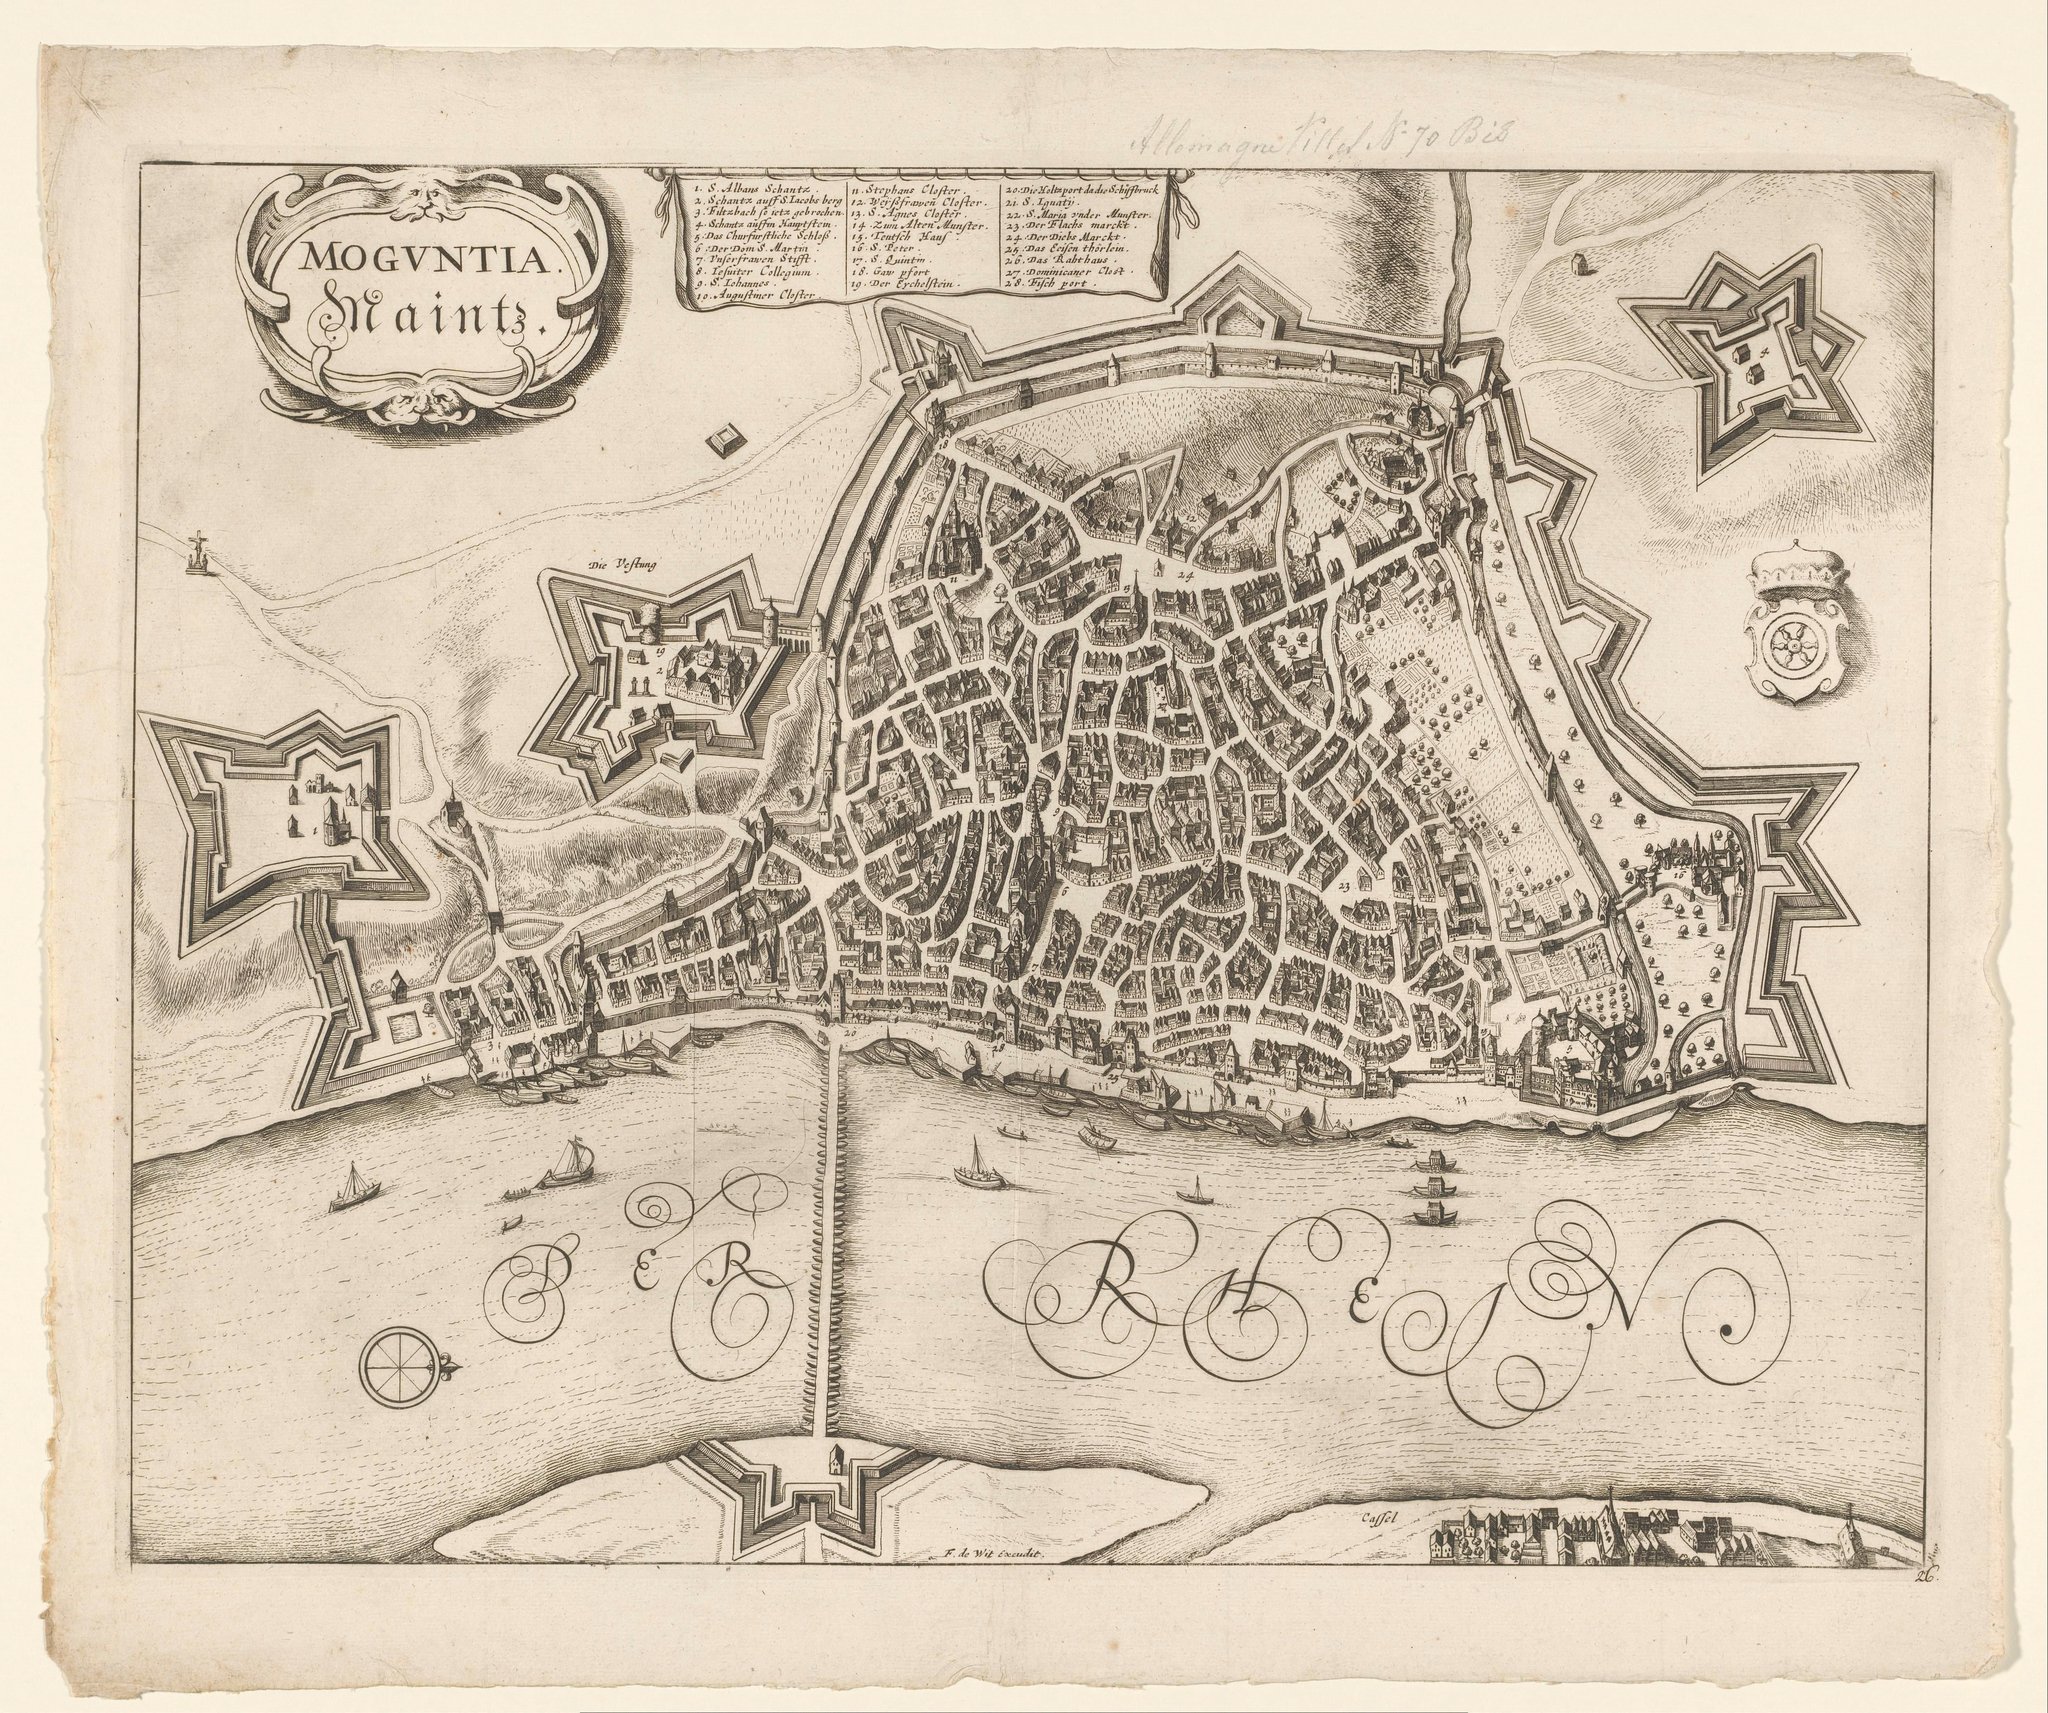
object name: print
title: Moguntia. Maintz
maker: Anonymous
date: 1657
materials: paper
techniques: engraving, etching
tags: coat of arms (as symbol of the state, etc.) (+ city; municipal), maps of cities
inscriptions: collector's mark: Lugt 2228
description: Plattegrond van Mainz met gebouwen in vogelvluchtperspectief. Rechtsboven een wapenschild met het Rad van Mainz.